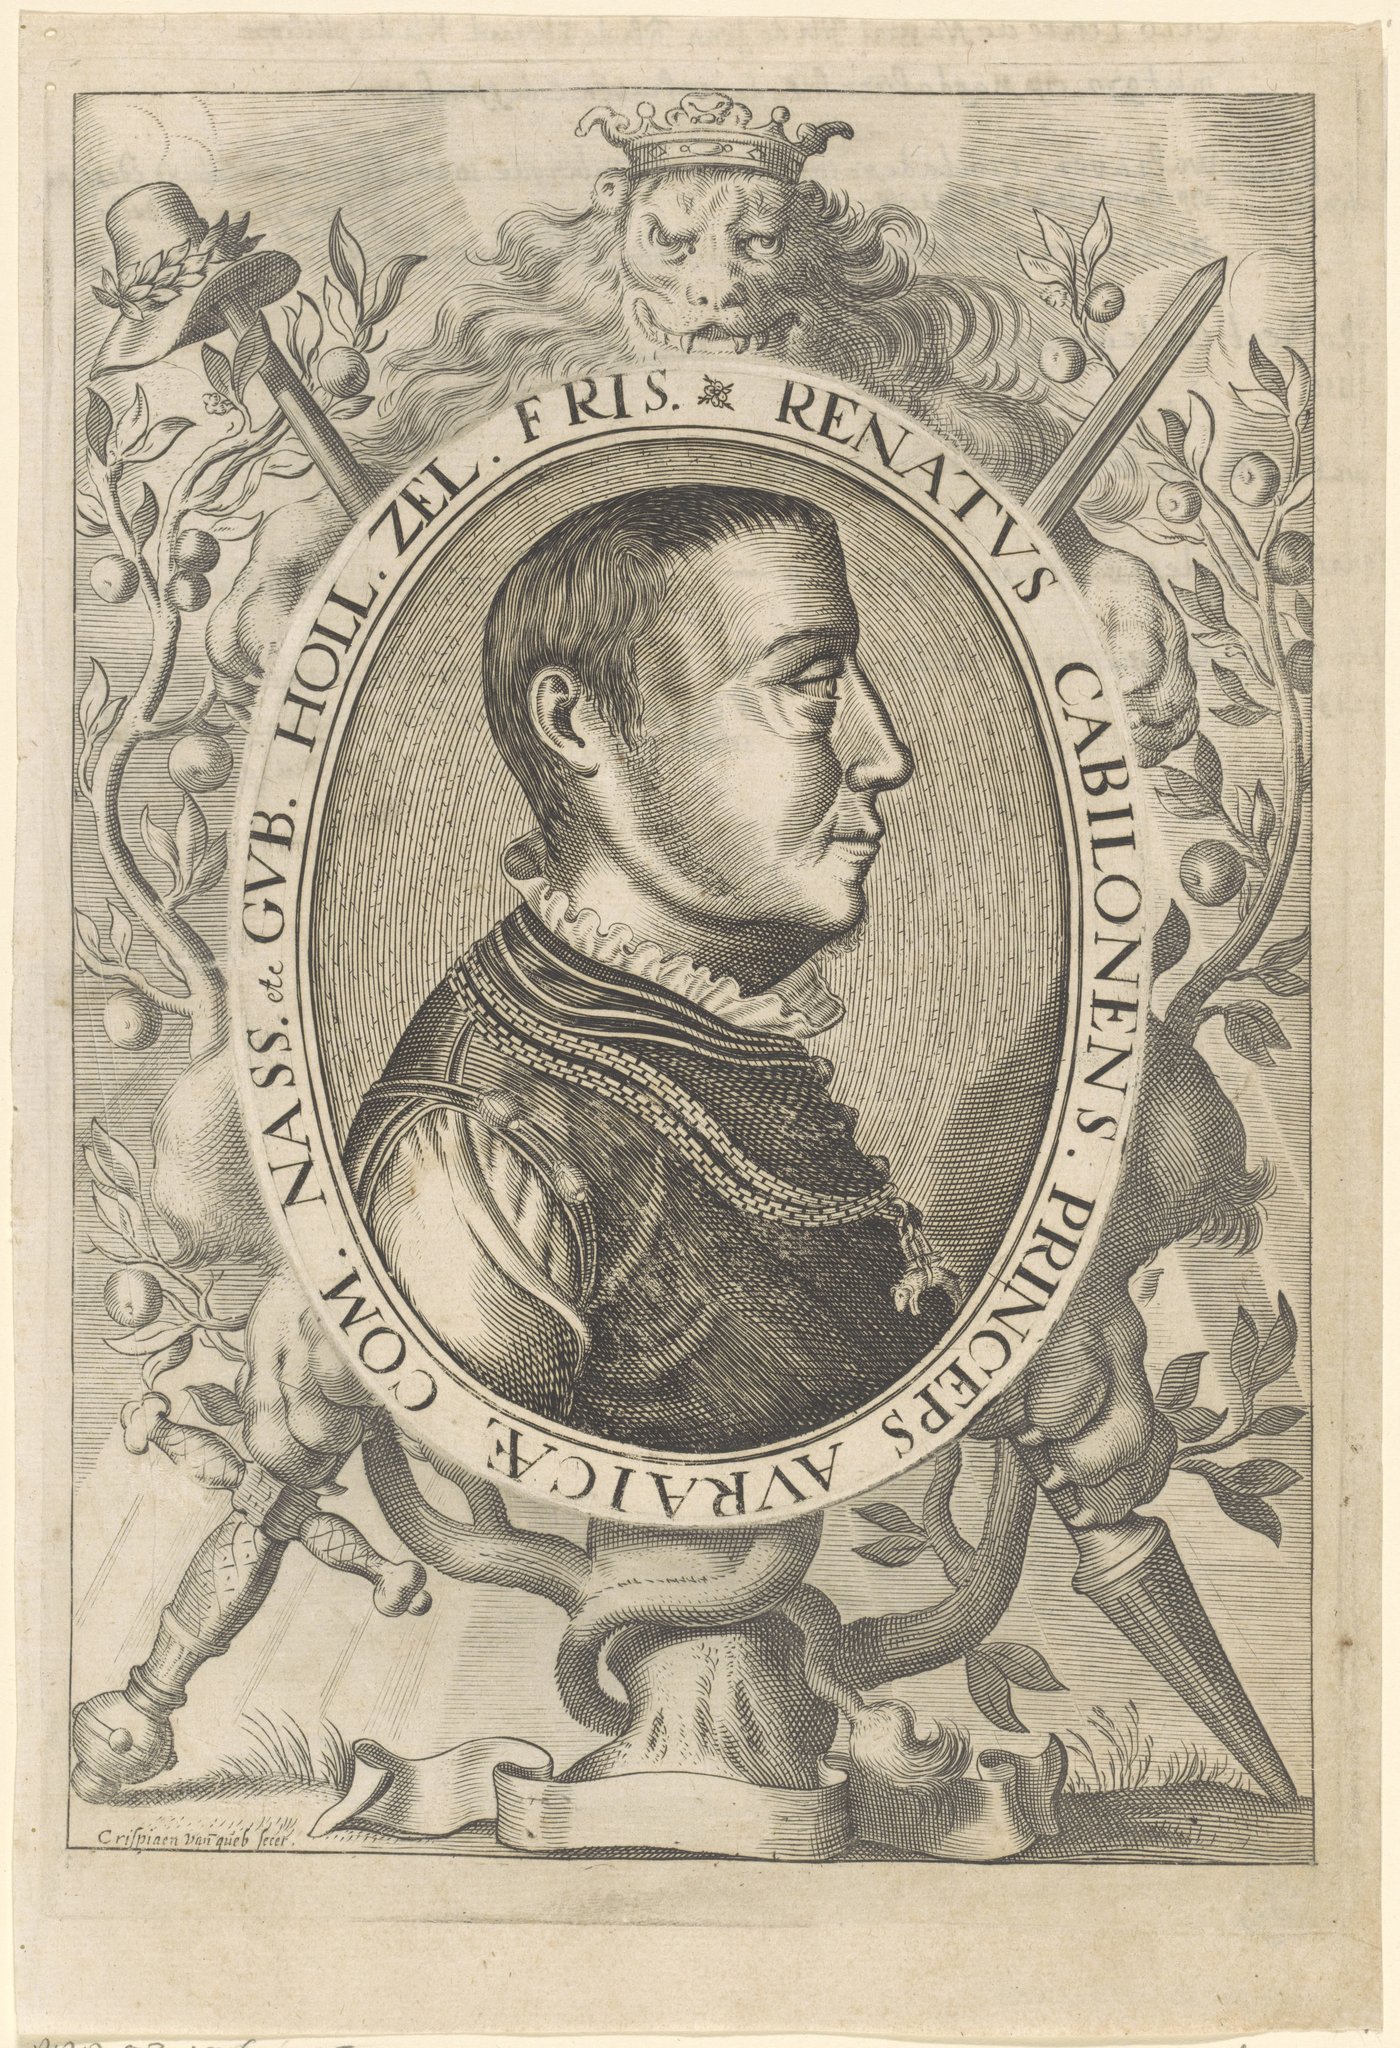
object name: print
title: Portret van René van Châlon, prins van Oranje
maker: crispijn van den queborn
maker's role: print maker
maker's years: 1595-1652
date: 1624-1652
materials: paper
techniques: engraving, etching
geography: the hague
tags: knighthood order of the golden fleece - insignia of a knighthood order, e.g.: badge, chain (with name of order)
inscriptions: collector's mark: Lugt 963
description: De hier vermelde titel verwijst naar de hoogst verkregen titel van de geportretteerde, niet per se naar de titel die de geportretteerde op deze voorstelling draagt.